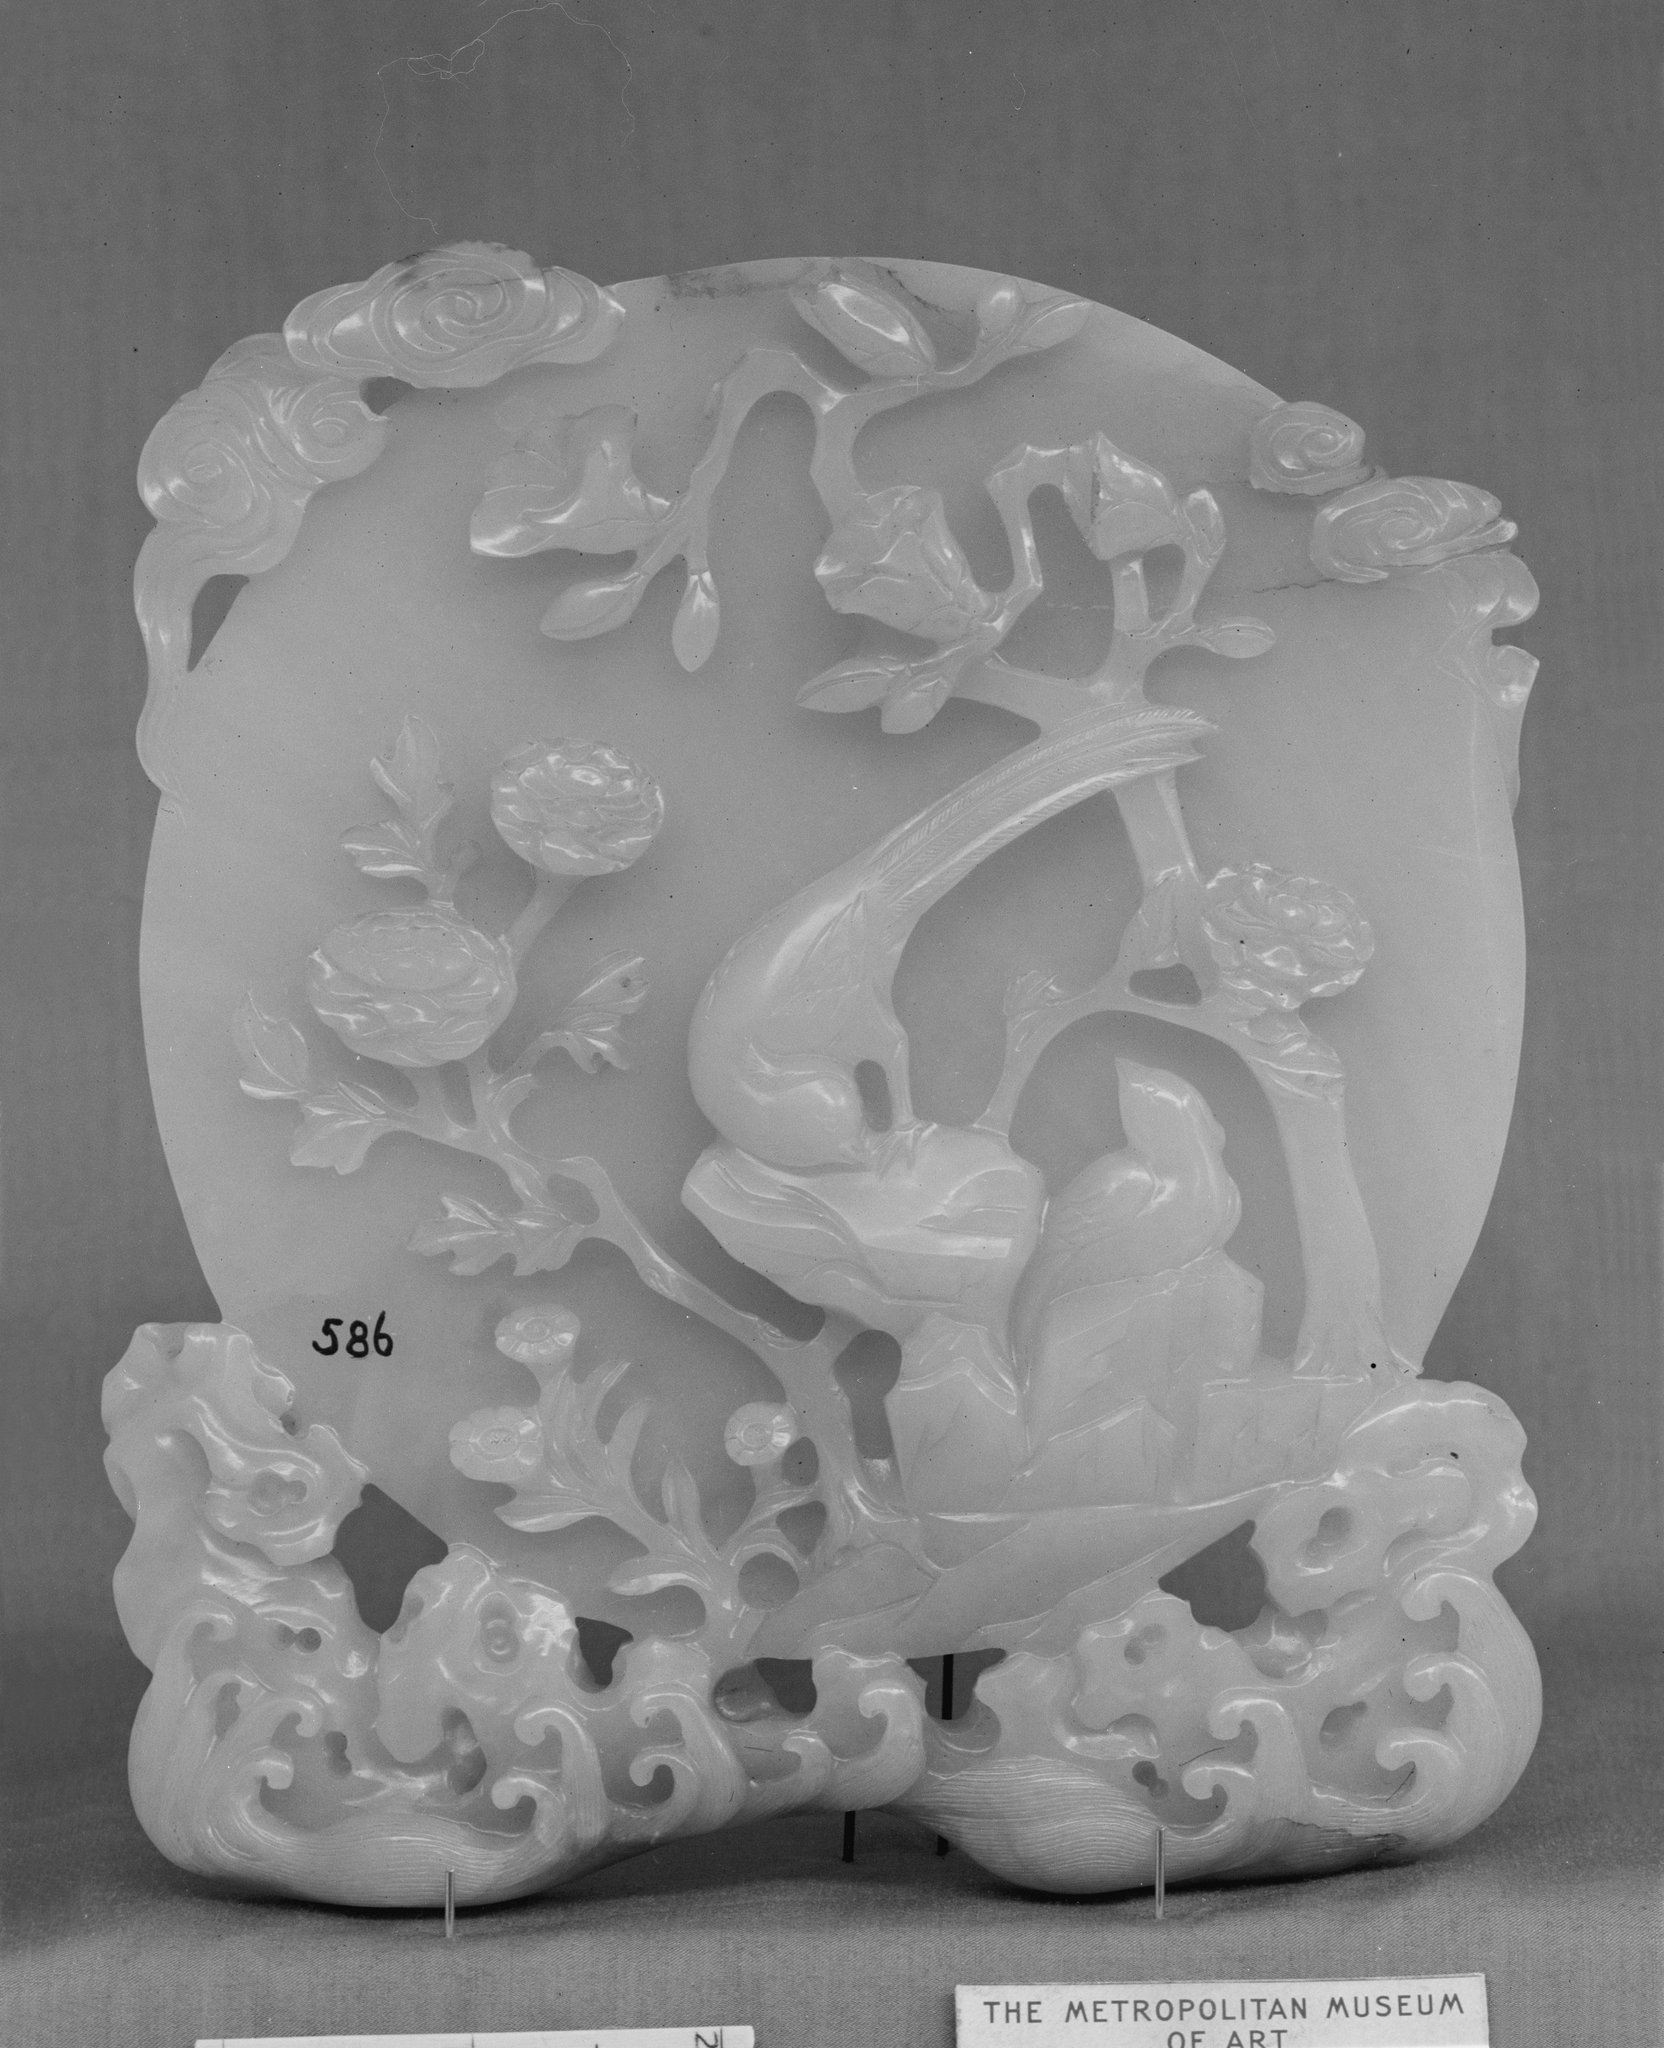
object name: table screen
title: Table Screen with Pheasant and Magnolia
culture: chinese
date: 1701-1800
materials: jade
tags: pheasants,flowers